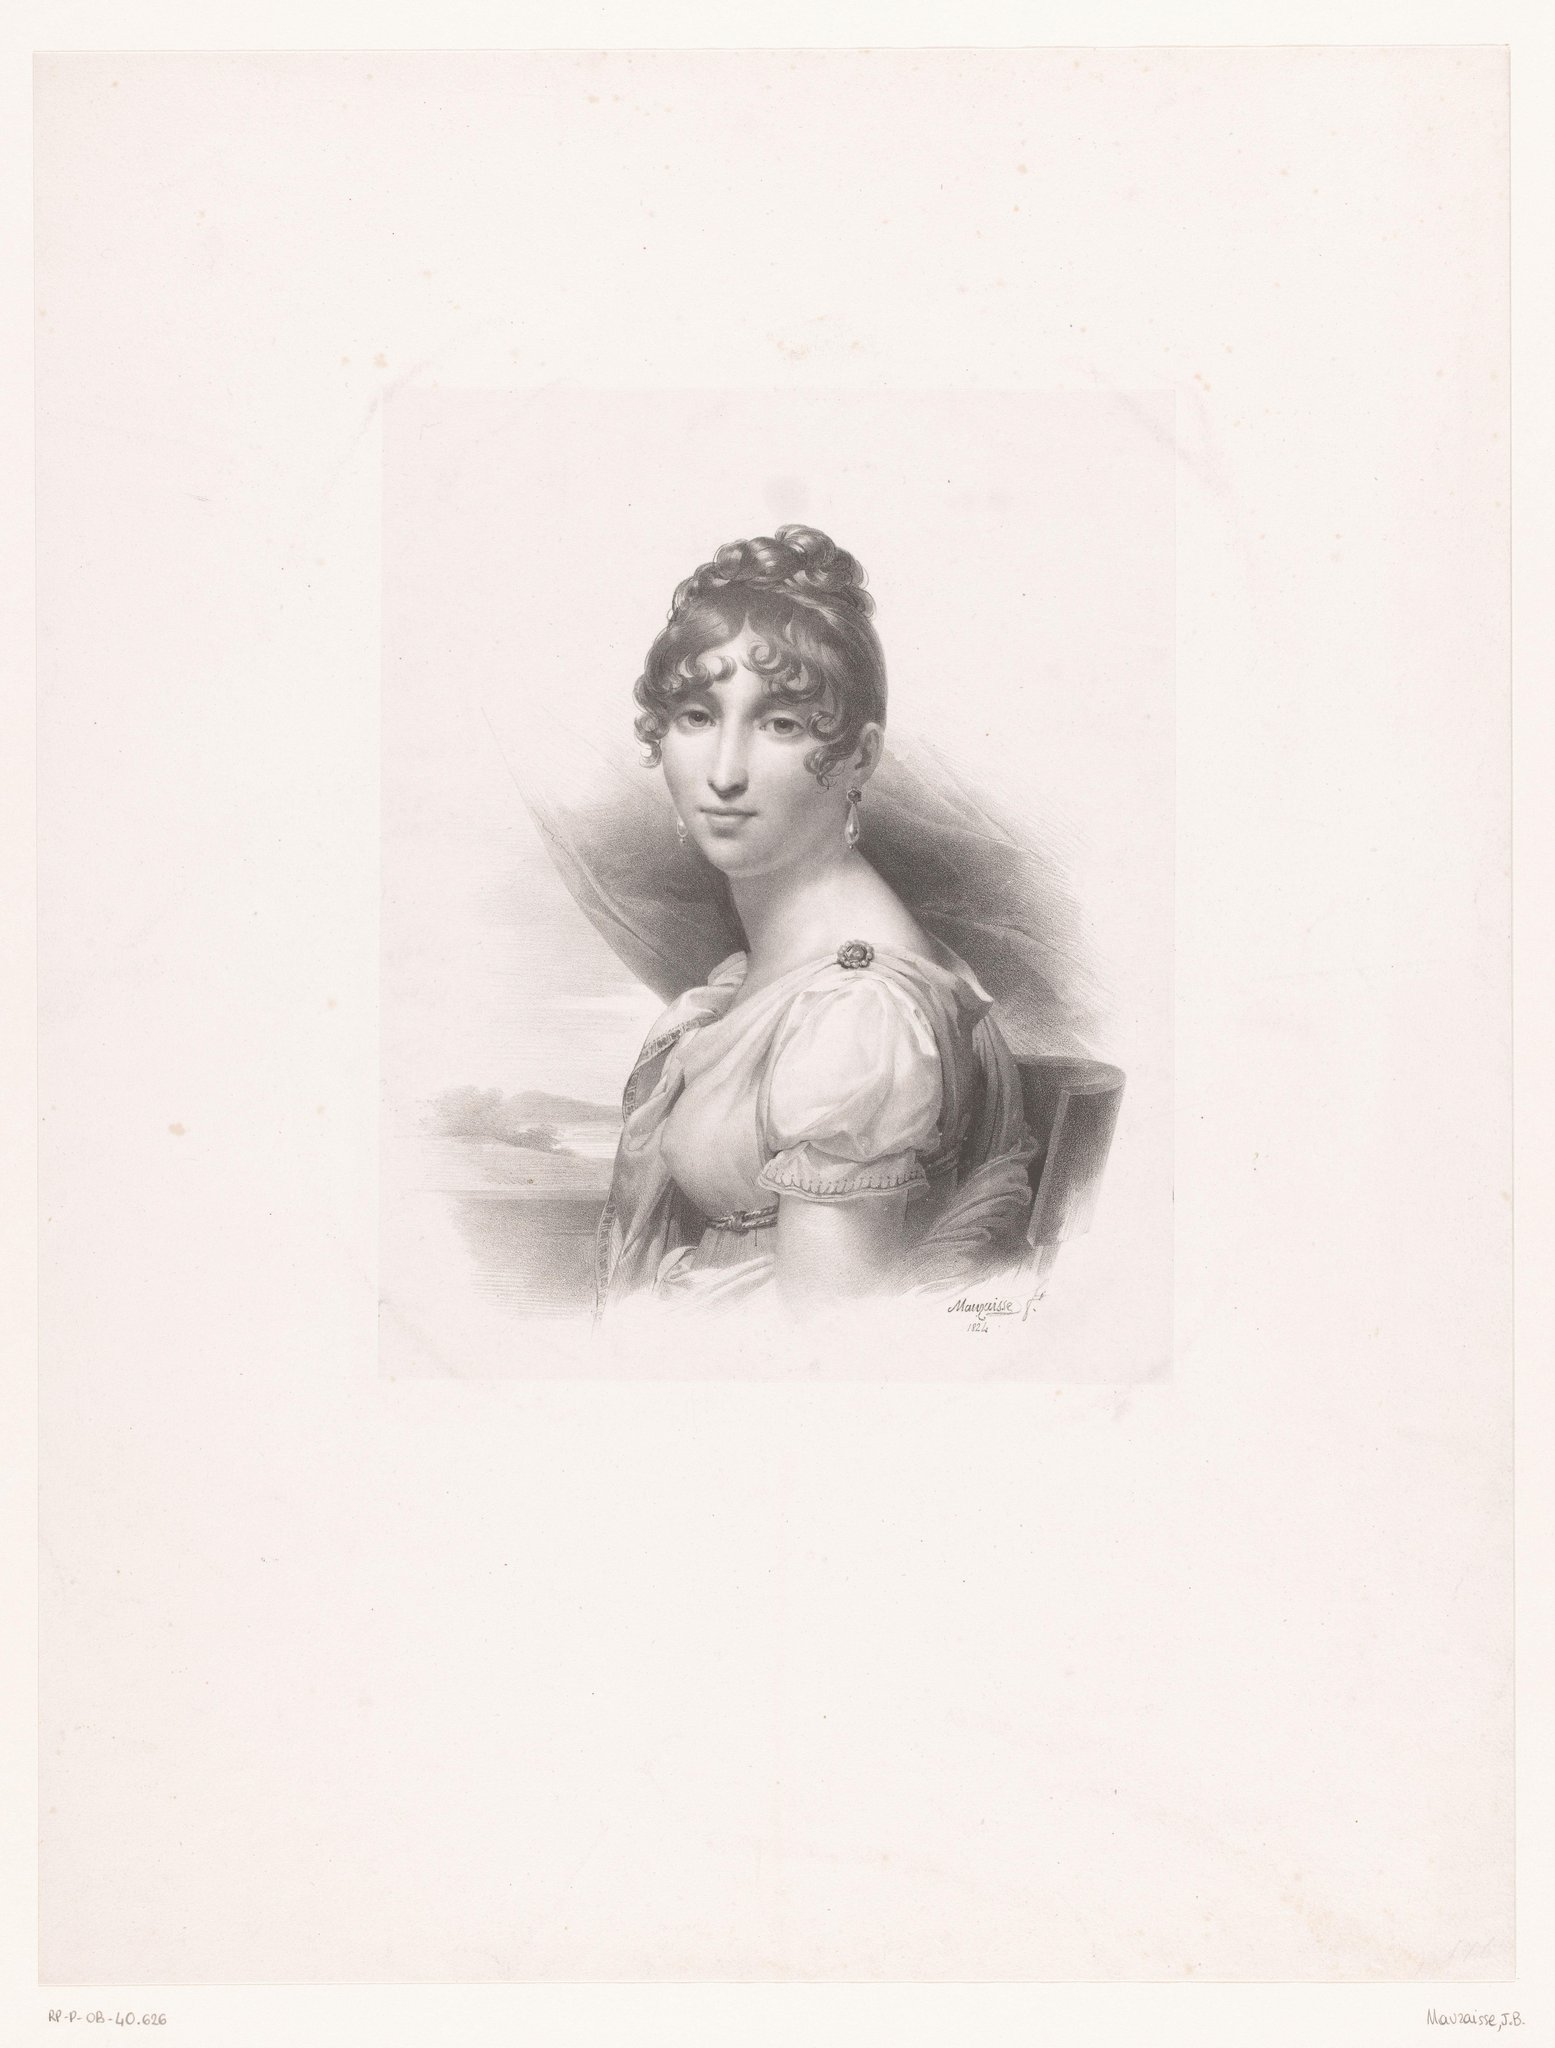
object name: print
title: Portret van een vrouw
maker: jean baptiste mauzaisse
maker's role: print maker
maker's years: 1784-1844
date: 1824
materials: paper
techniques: lithograph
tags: adult woman, historical persons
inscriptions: date